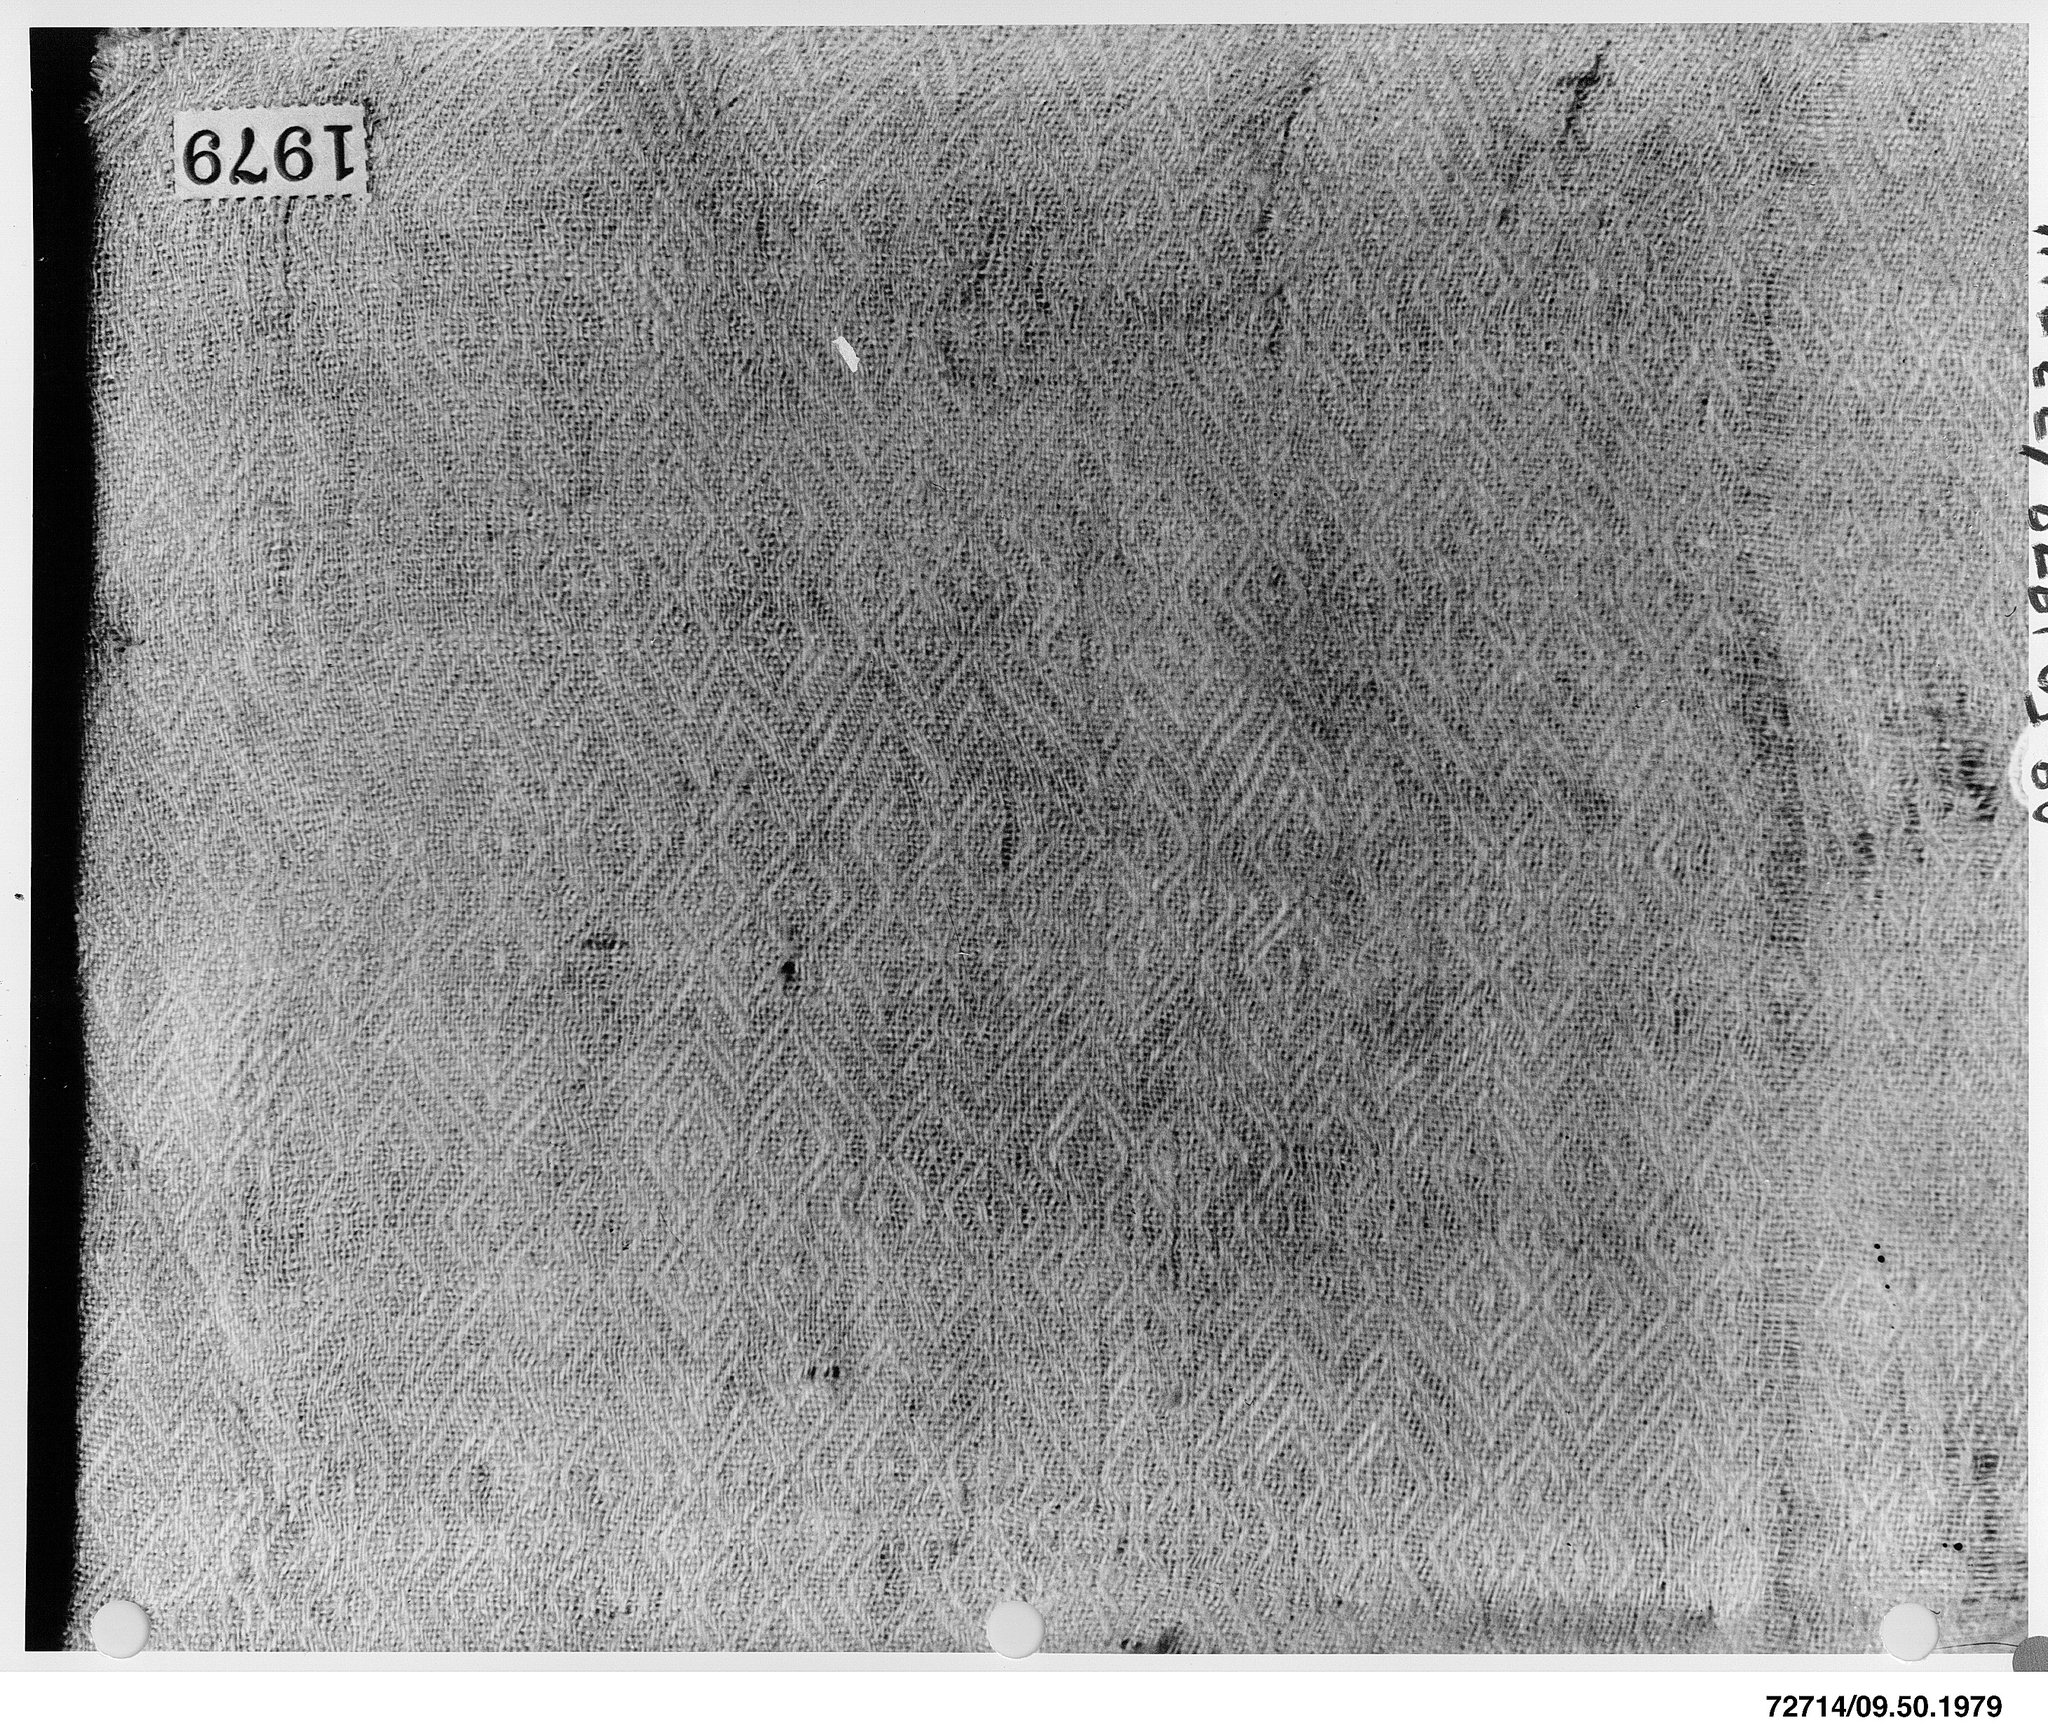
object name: piece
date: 1701-1900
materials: linen